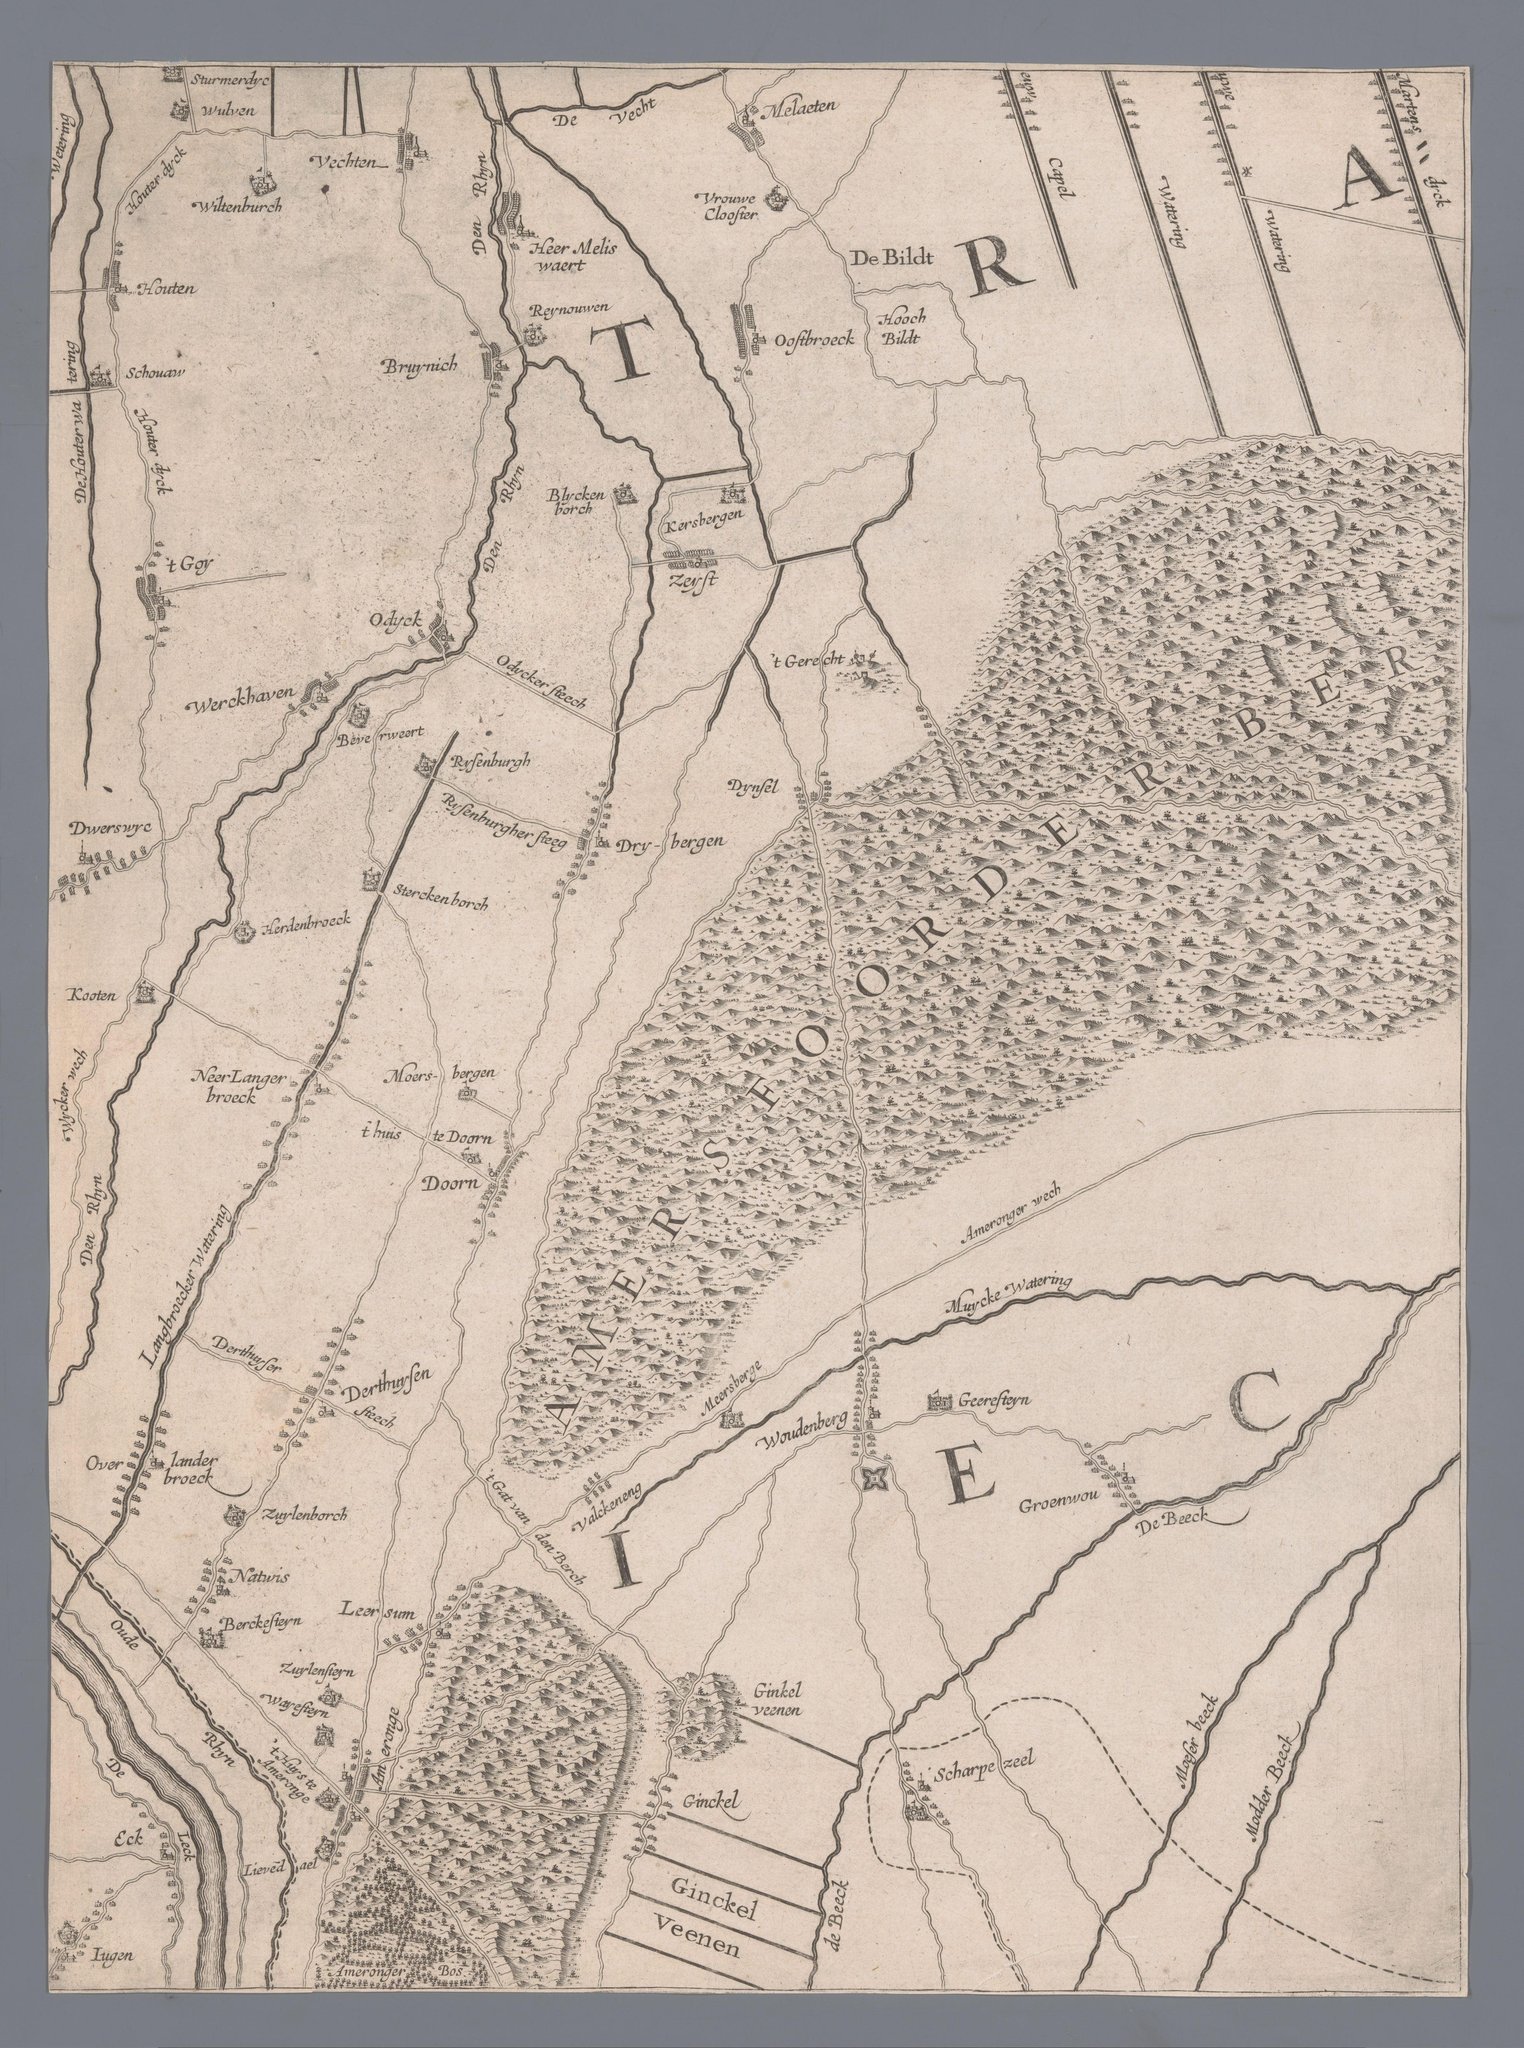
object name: map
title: Kaart van het Graafschap Holland en Utrecht (plaat 34)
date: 1639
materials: paper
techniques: engraving, etching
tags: maps, atlases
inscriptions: collector's mark: Lugt 2228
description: Onderdeel van een kaart samengesteld uit 40 bladen. Waarschijnlijk gaat het om de grootste kaart van Holland uit de zeventiende-eeuw. De kaart is uitgegeven in verschillende edities, deze kaart uit 1639 is de eerste editie.